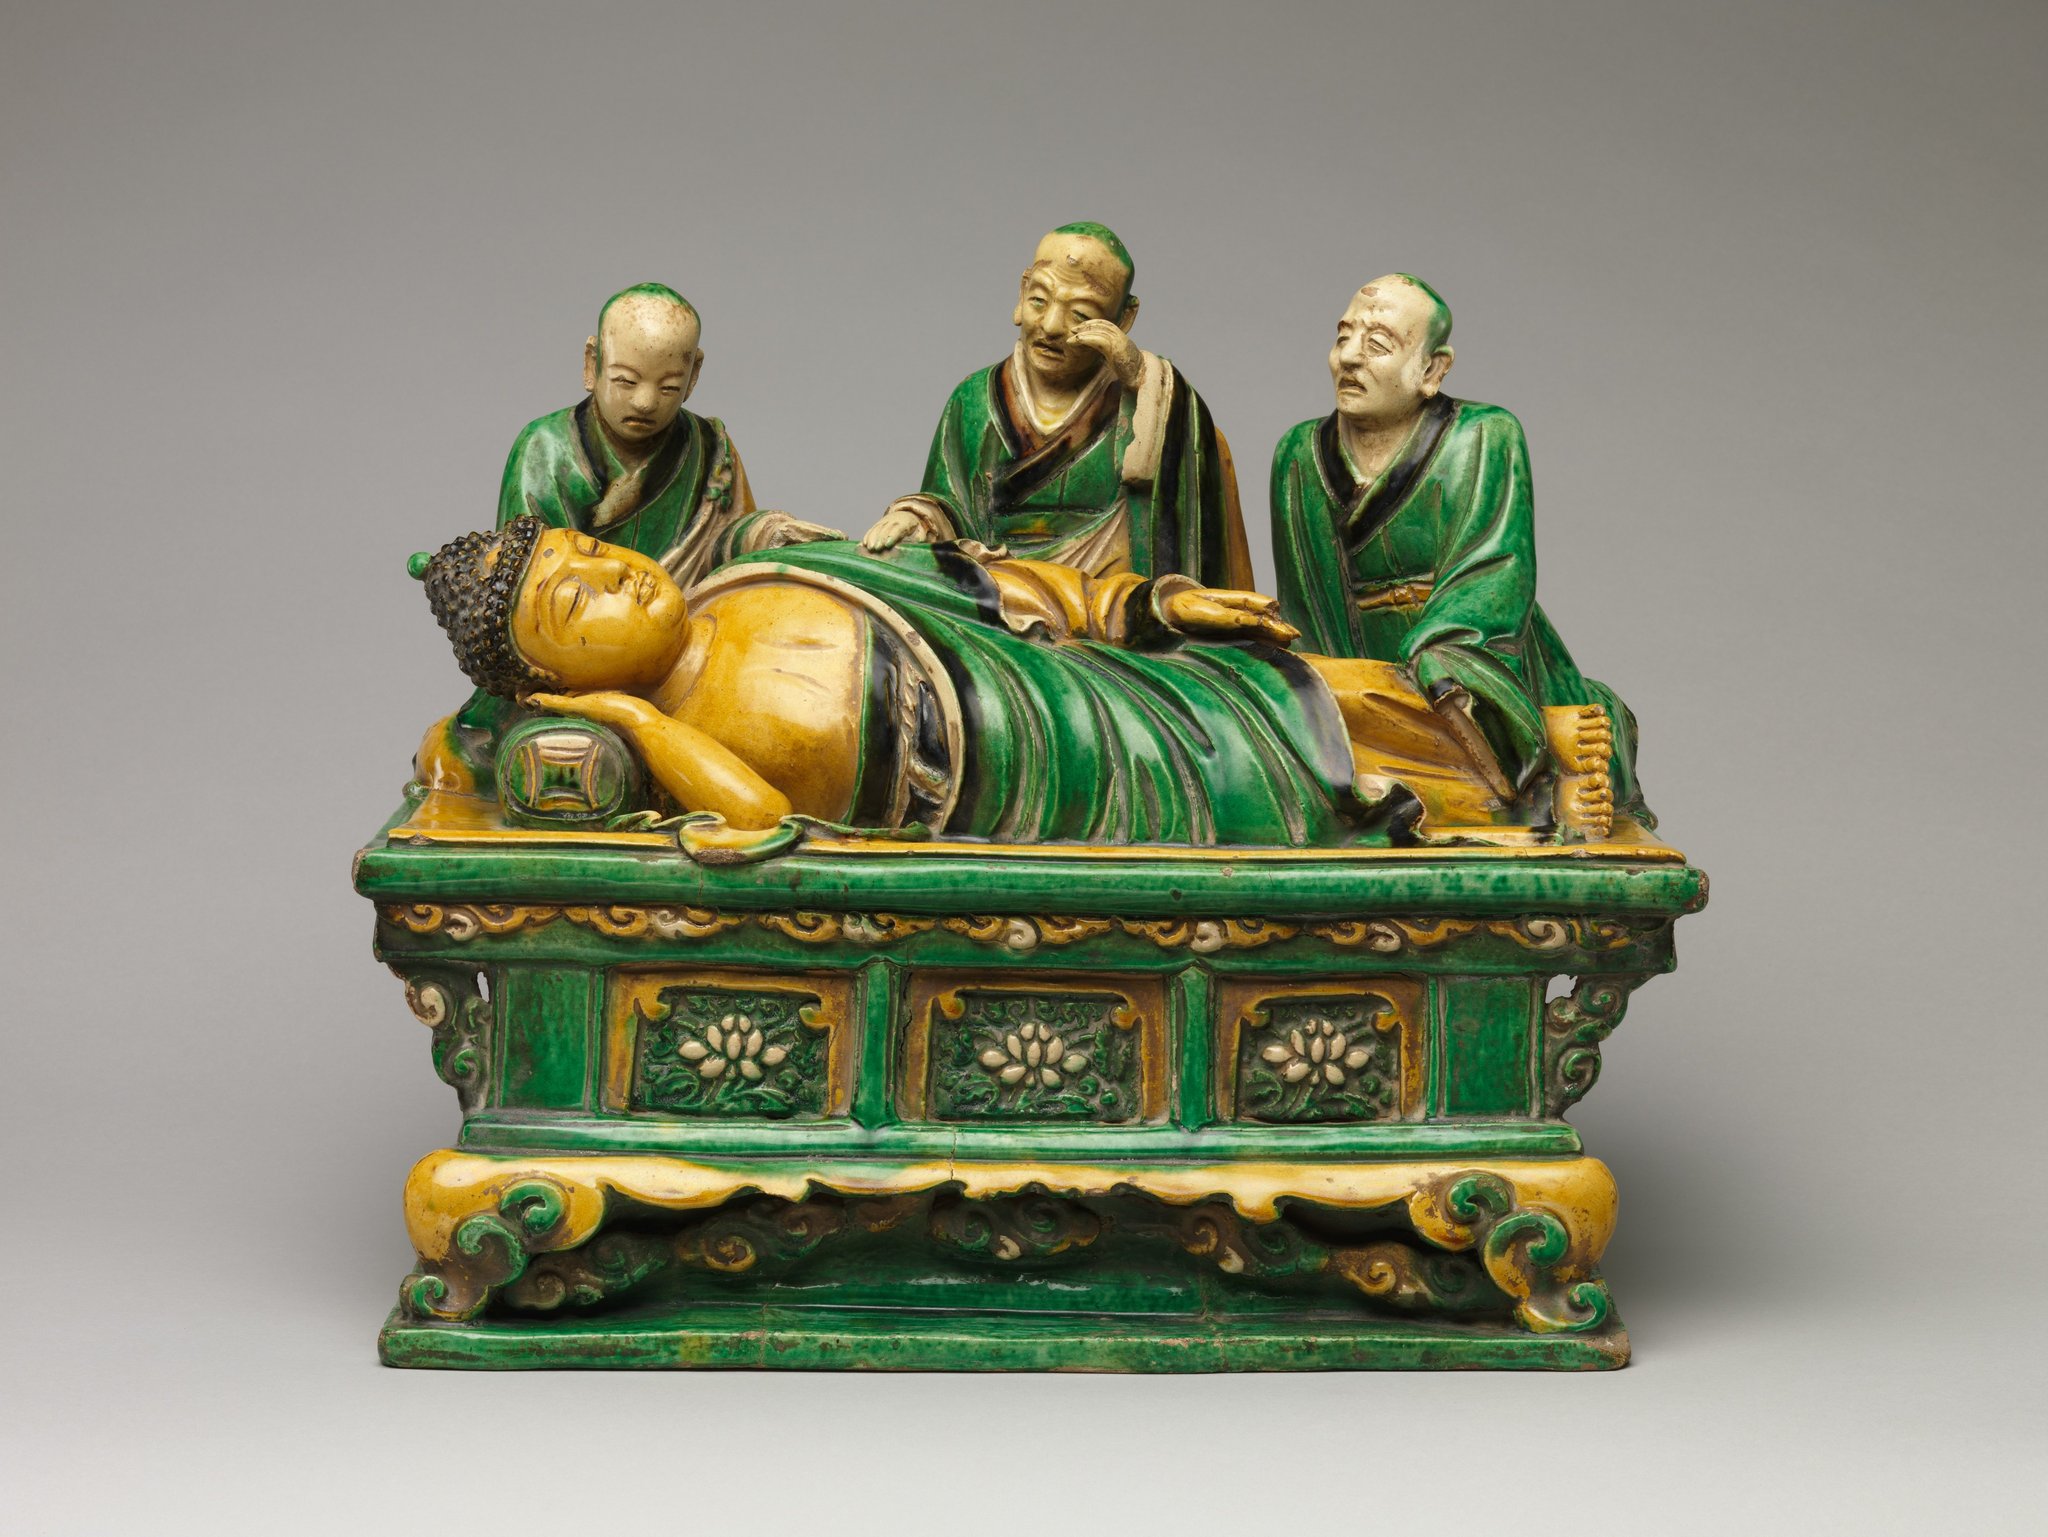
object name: group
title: Par nirvana (death and transcendence of the Buddha) and attendant arhats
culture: chinese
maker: qiao bin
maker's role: artist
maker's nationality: chinese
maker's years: 1481-1507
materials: earthenware, glaze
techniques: polychrome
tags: sadness,men,buddhism,buddha,death